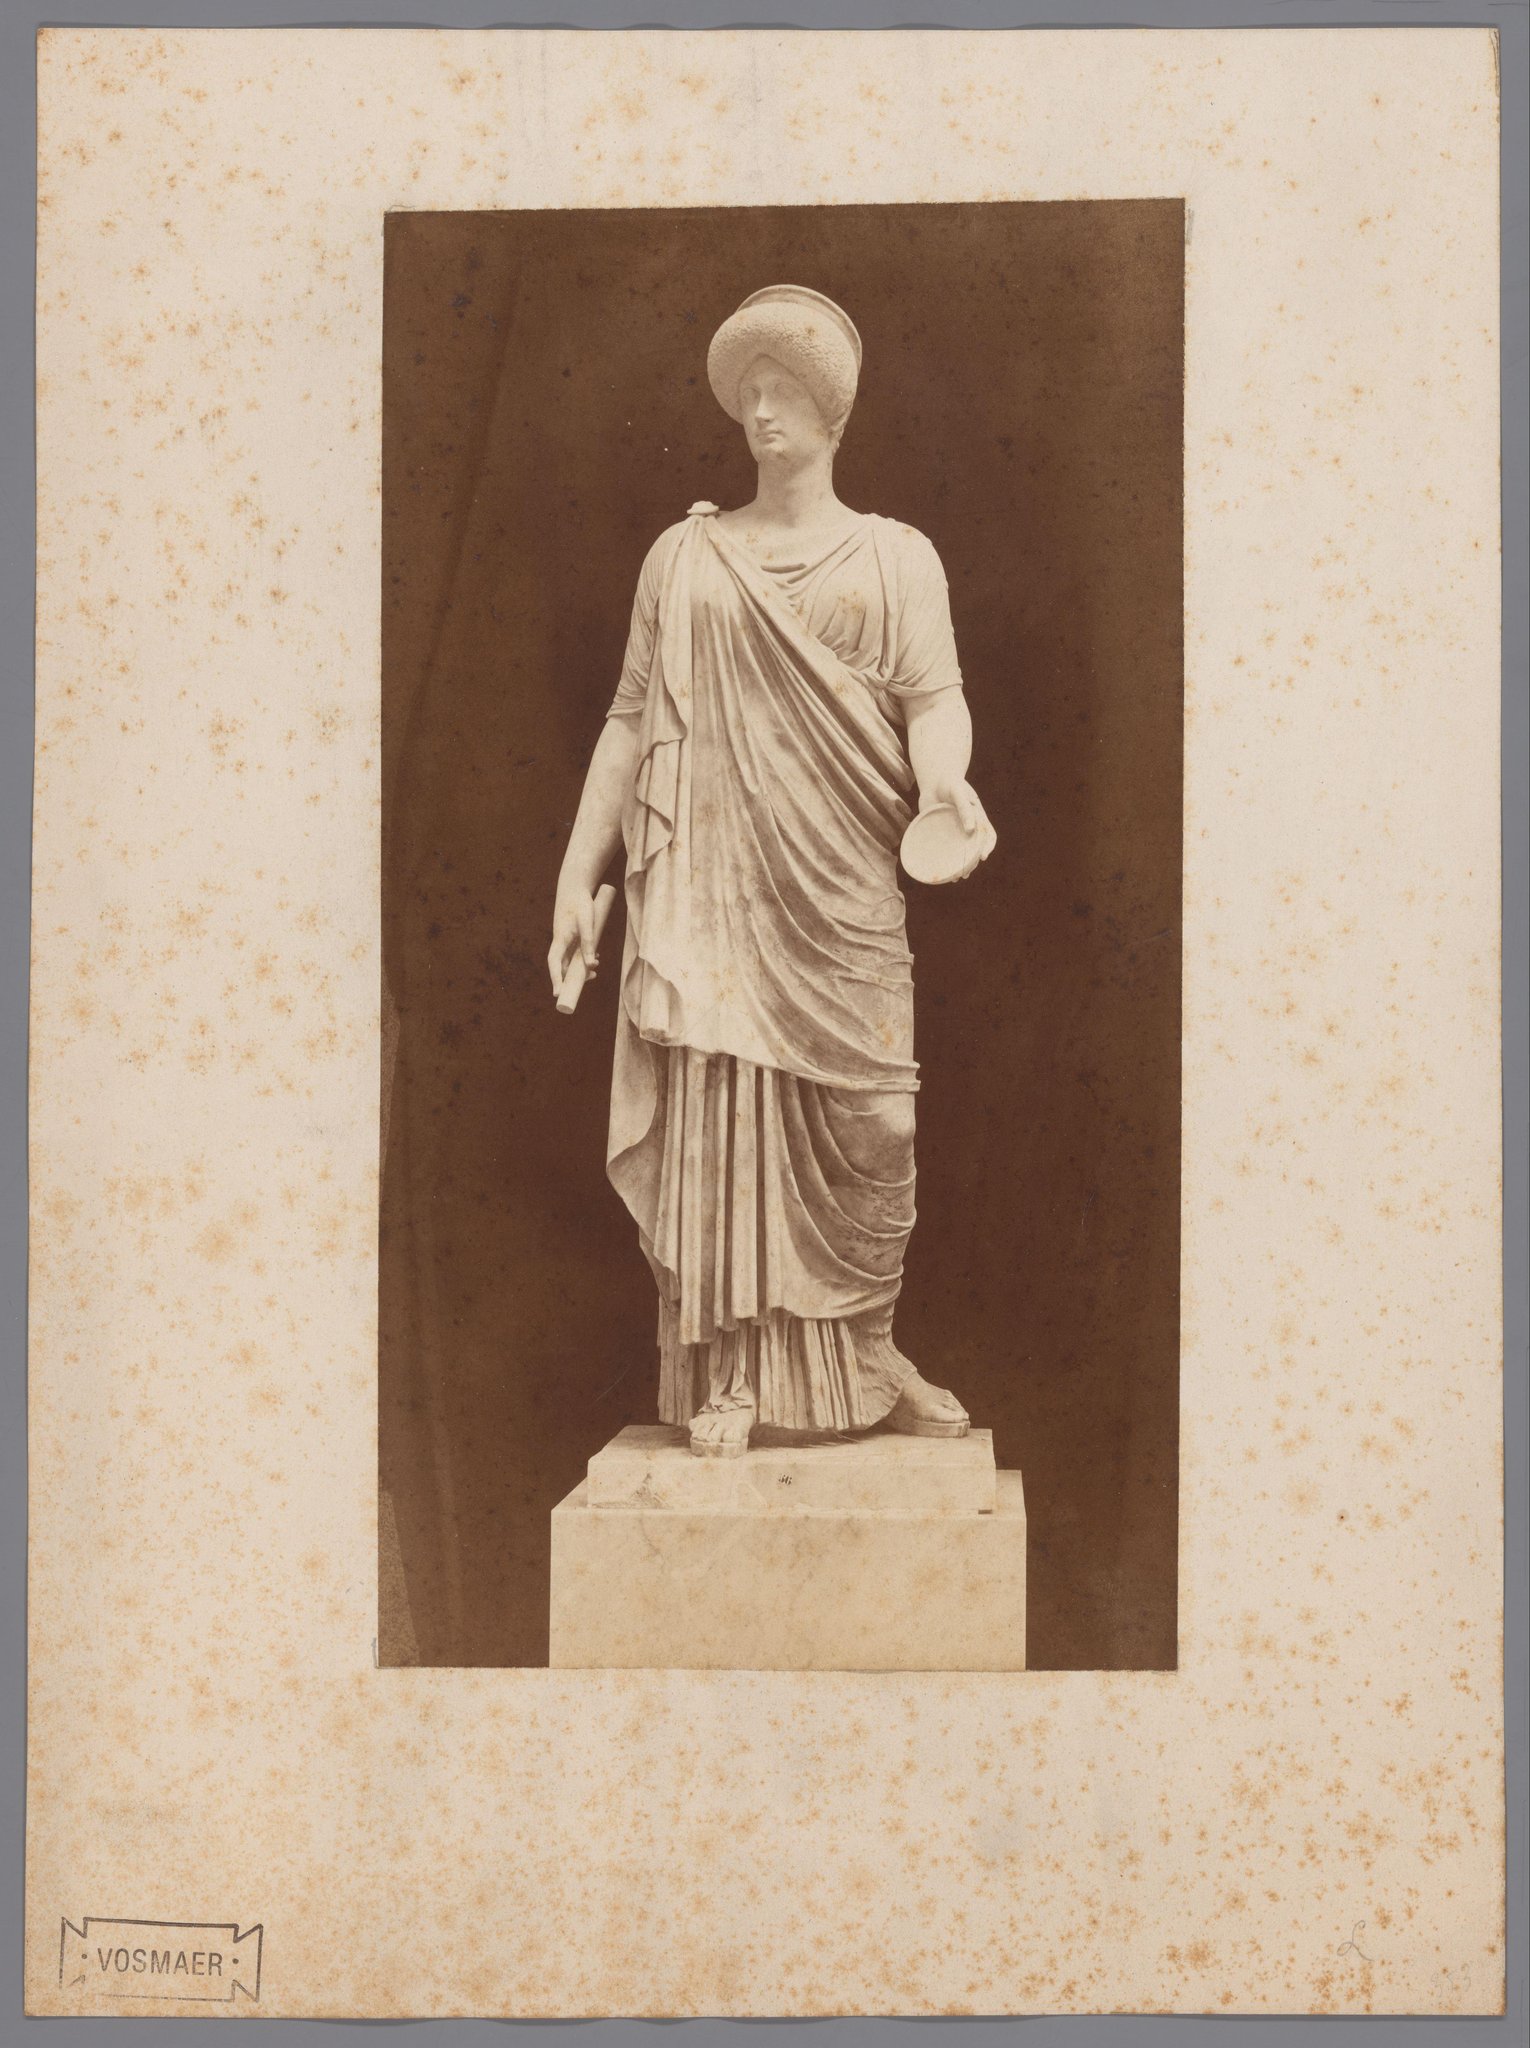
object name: photograph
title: Sculptuur van een staande Griekse of Romeinse vrouw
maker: Anonymous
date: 1851-1900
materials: cardboard, paper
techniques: albumen print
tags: piece of sculpture, reproduction of a piece of sculpture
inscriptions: collector's mark: ‘VOSMAER’, inscription: ‘L’